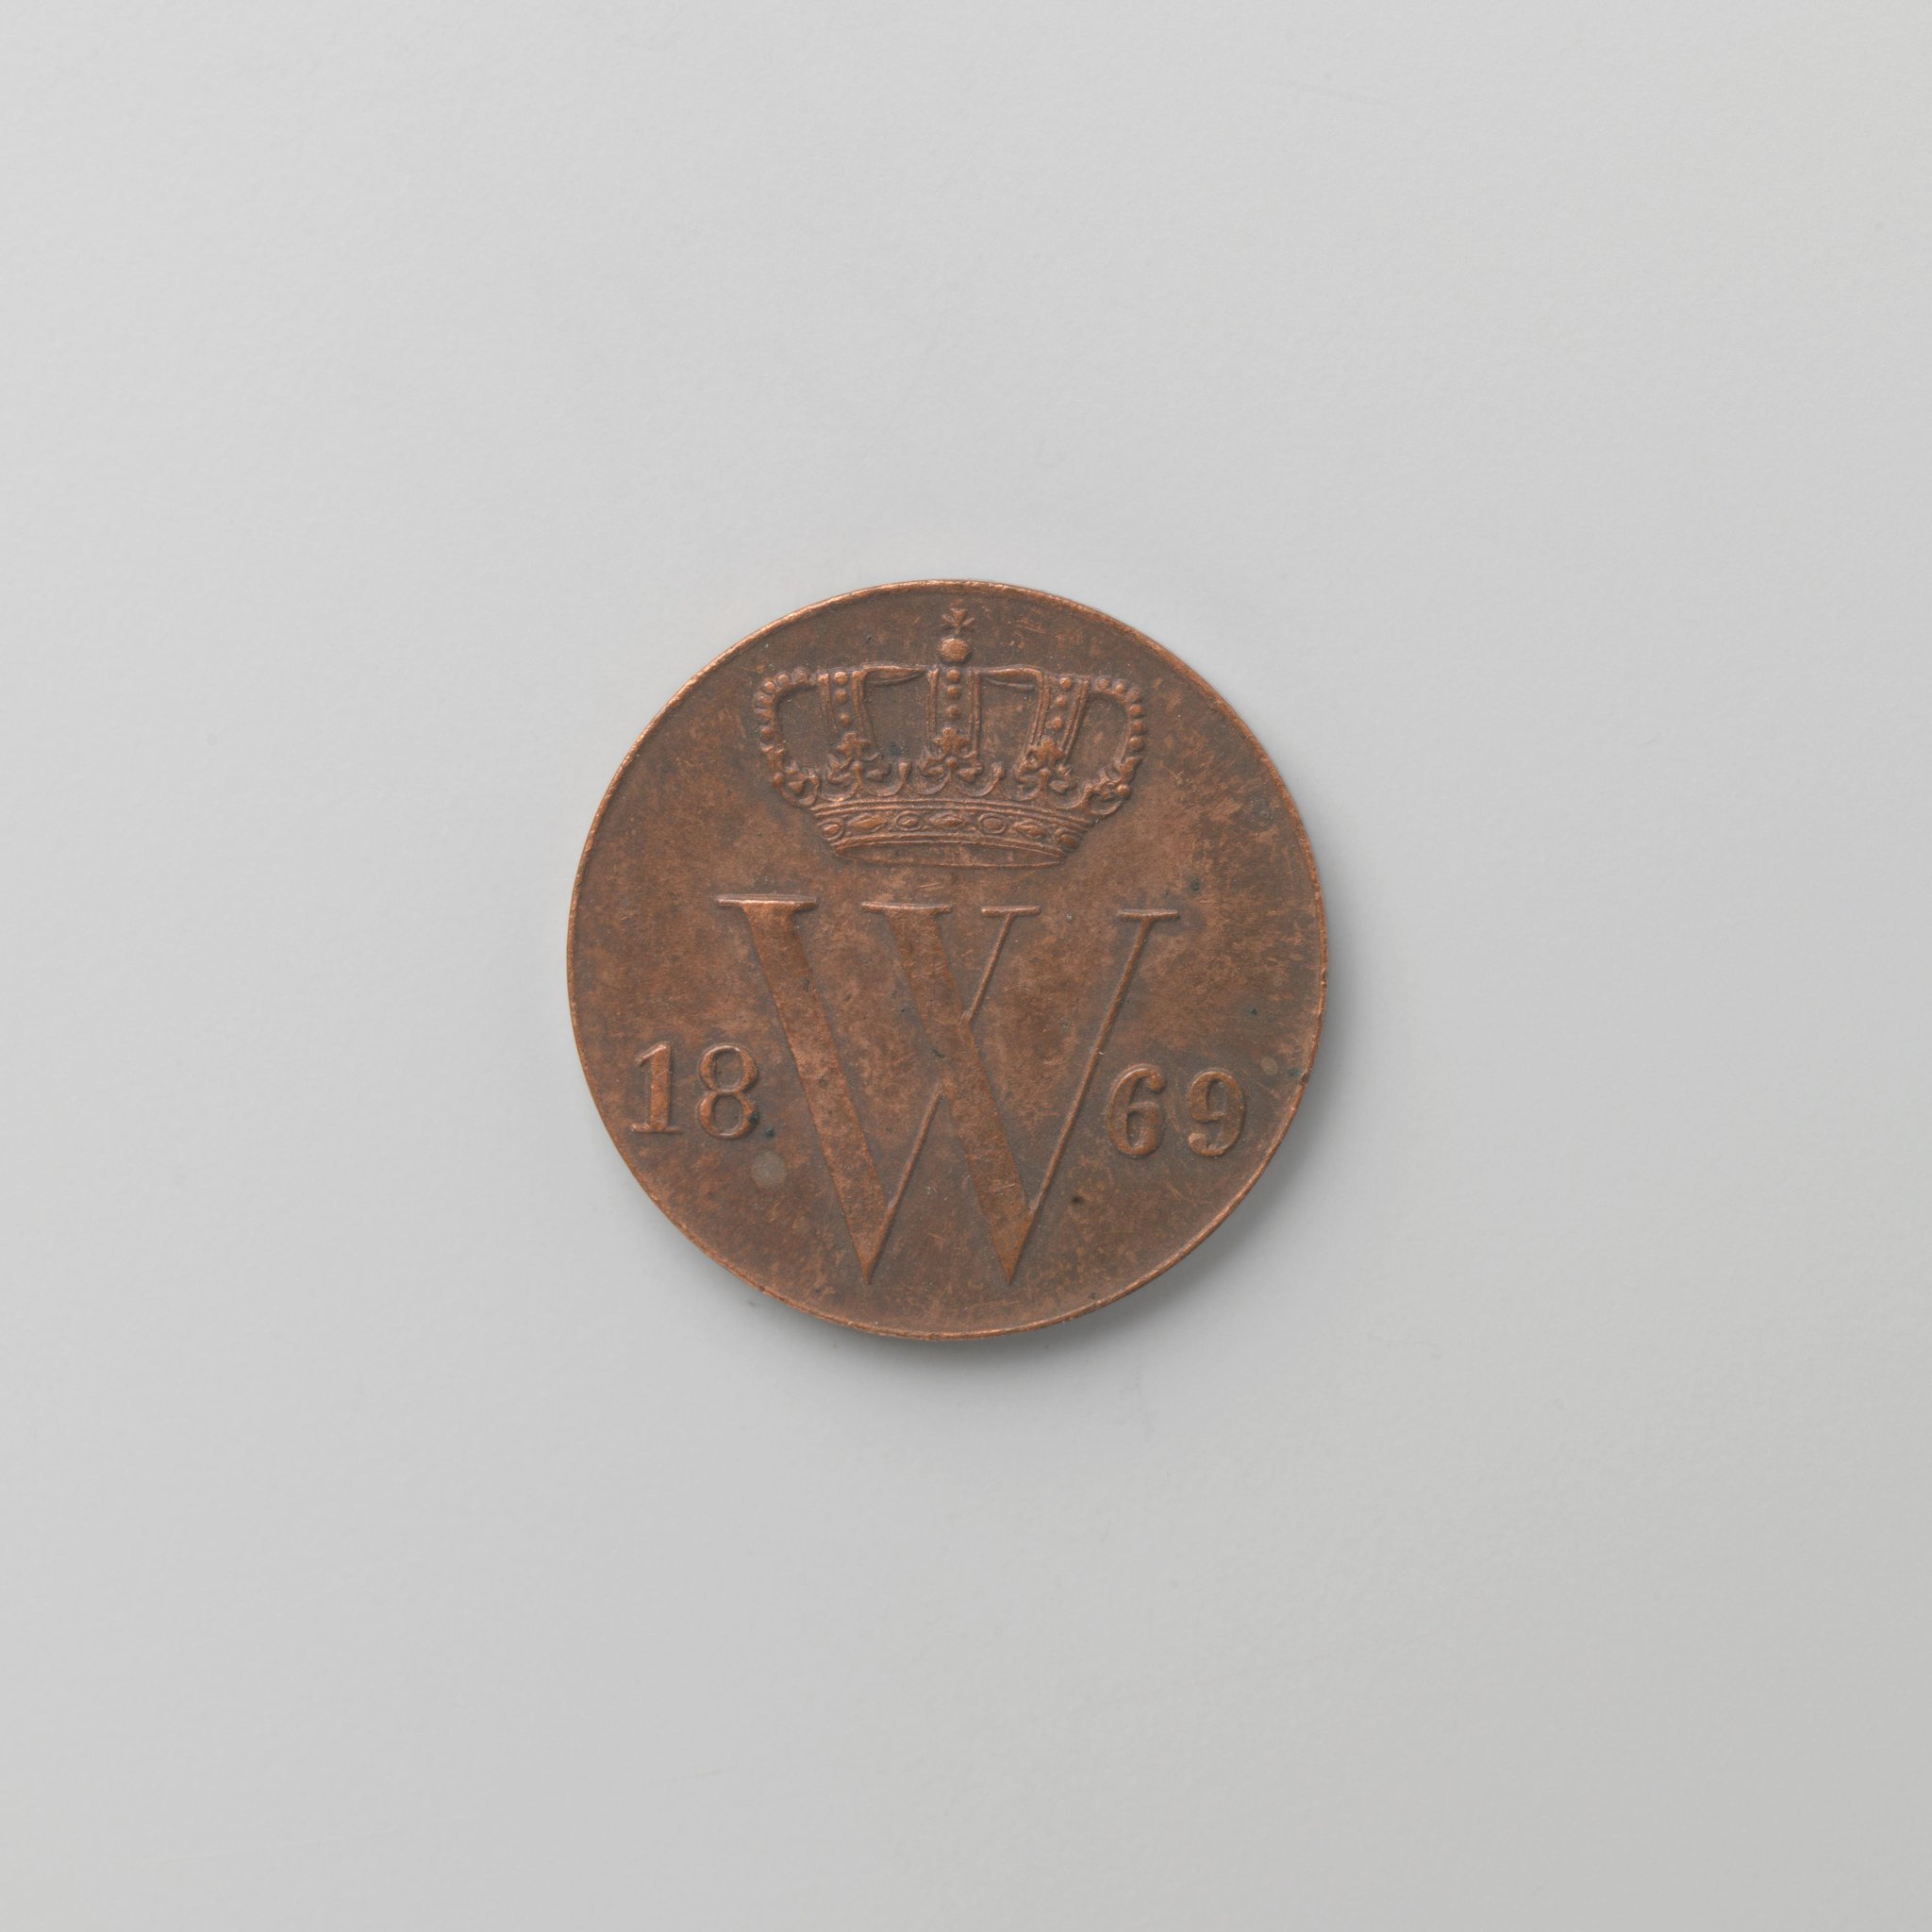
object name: coin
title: Nederlandse ½ cent, 1869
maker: willem iii (koning der nederlanden)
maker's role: koning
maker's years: 1817-1890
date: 1869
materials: copper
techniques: striking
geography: utrecht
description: Koperen munt. Voorzijde: tussen jaartal gekroonde rechte letter W. Keerzijde: tussen waarde-aanduiding ½ C. gekroond rijkswapenschild. Gladde rand.